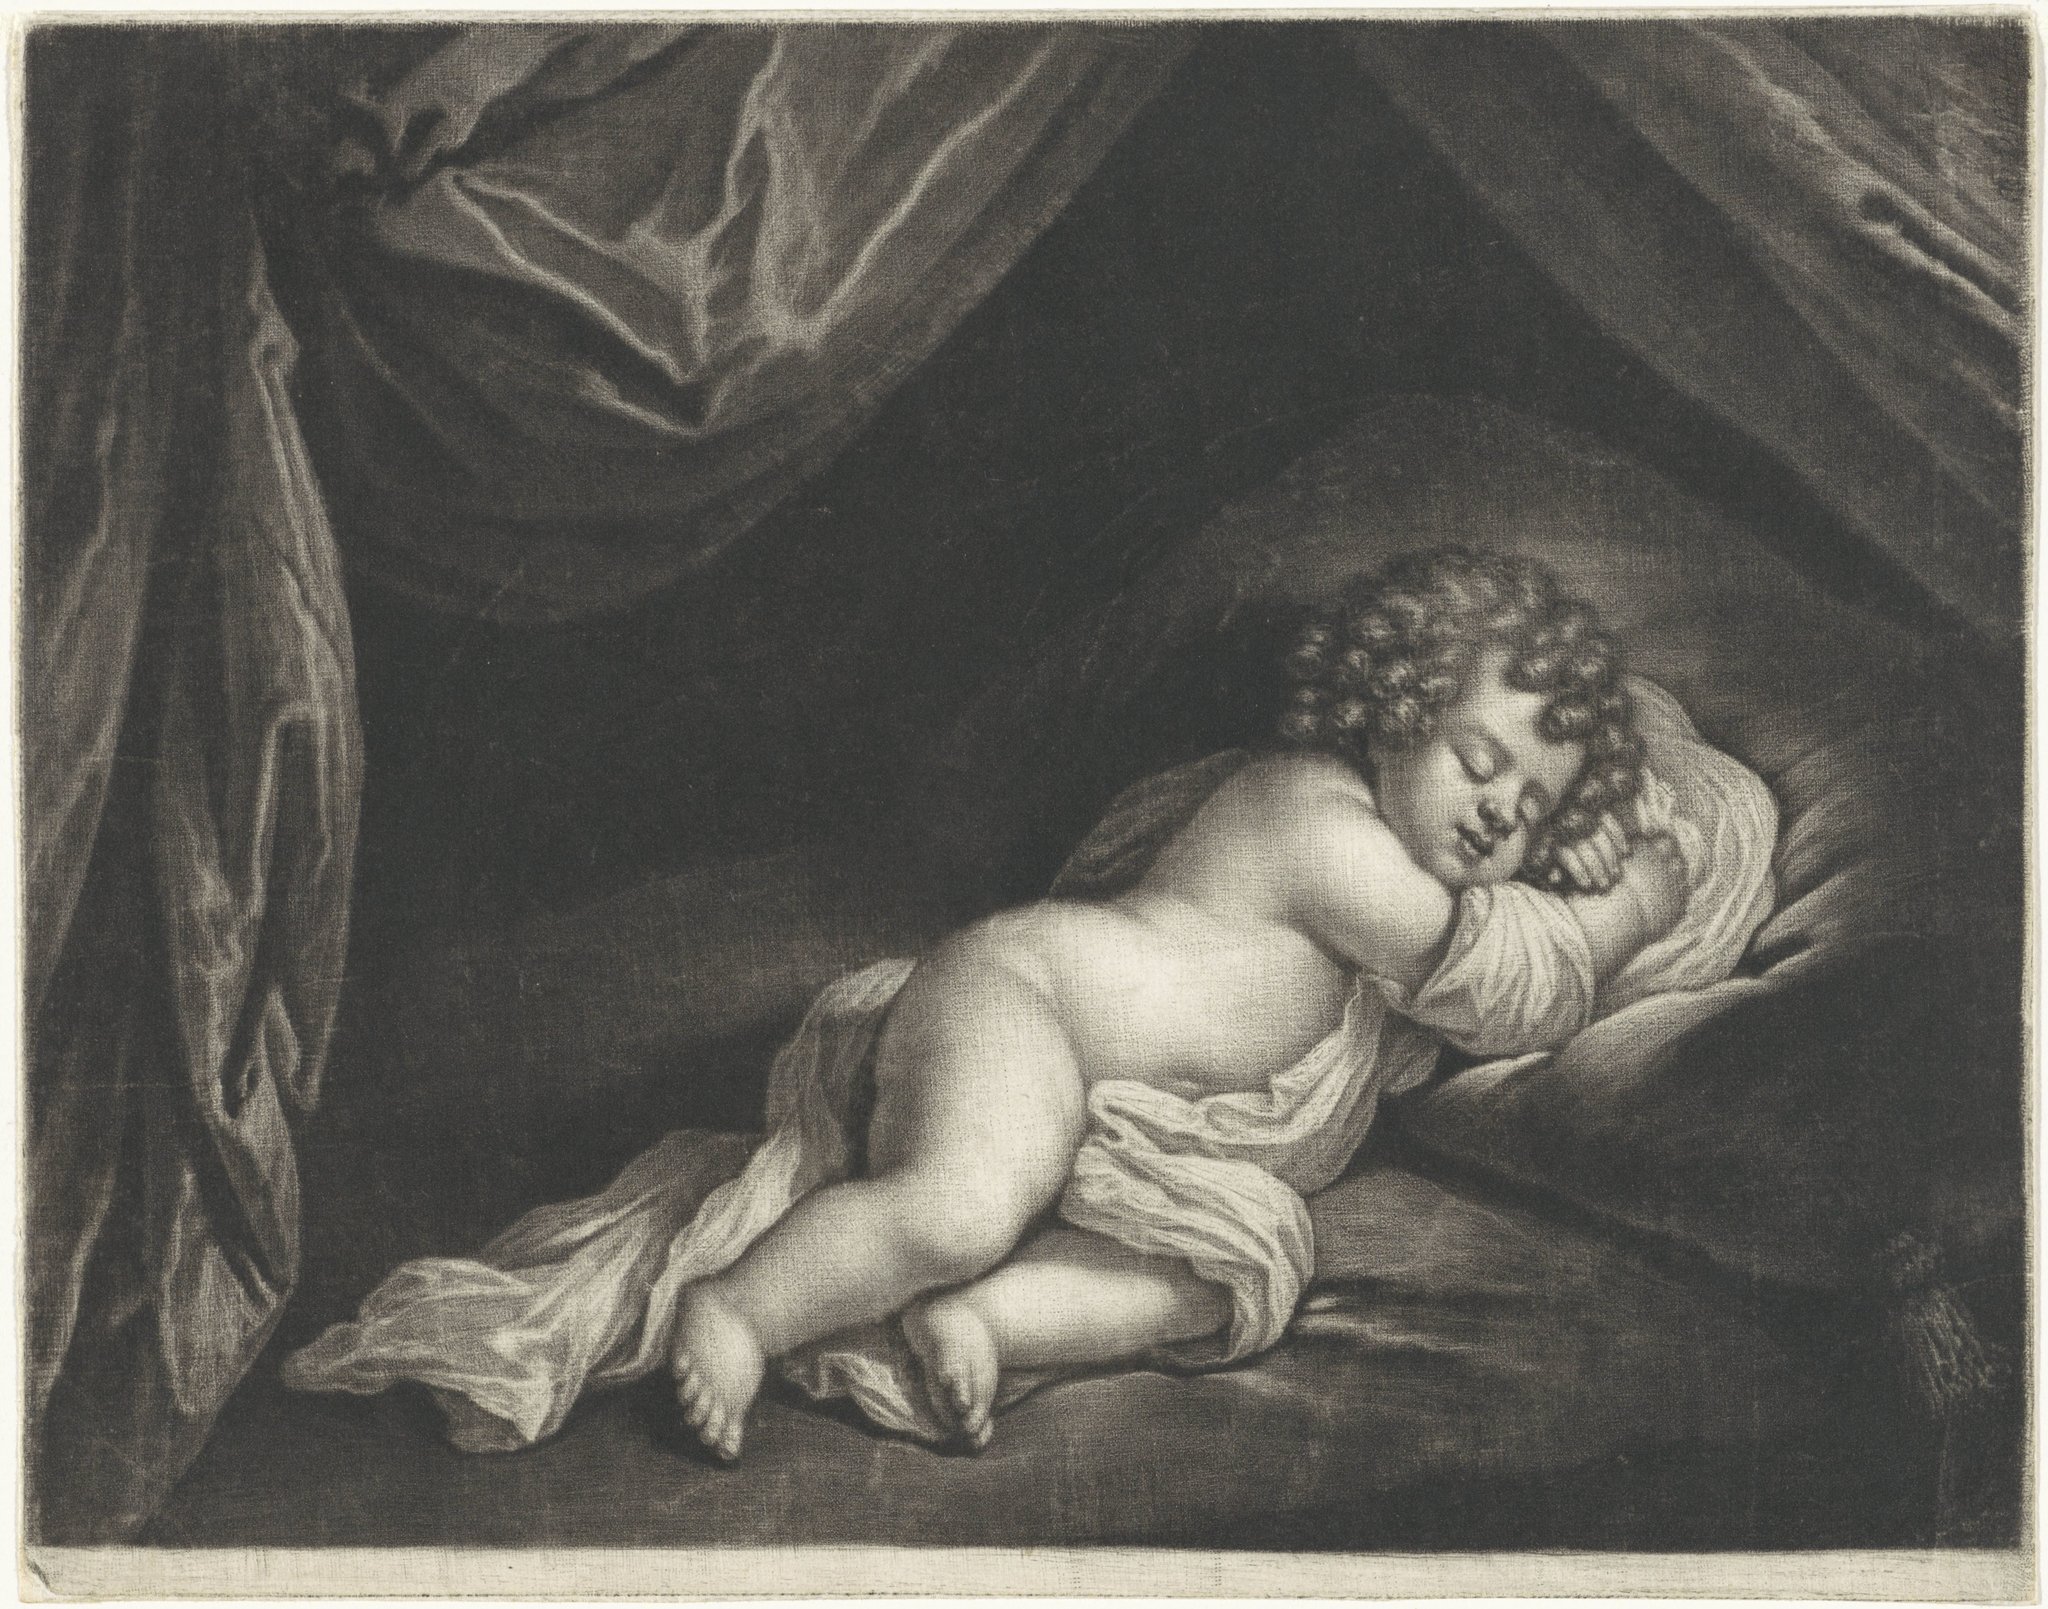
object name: print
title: Slapende Amor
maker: wallerant vaillant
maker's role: draughtsman, painter, print maker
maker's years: 1623-1677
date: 1658-1677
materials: paper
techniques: mezzotint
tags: sleeping in bed, (story of) cupid, amor (eros)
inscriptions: collector's mark: Lugt 2228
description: Amor ligt in een bed onder een baldakijn te slapen.